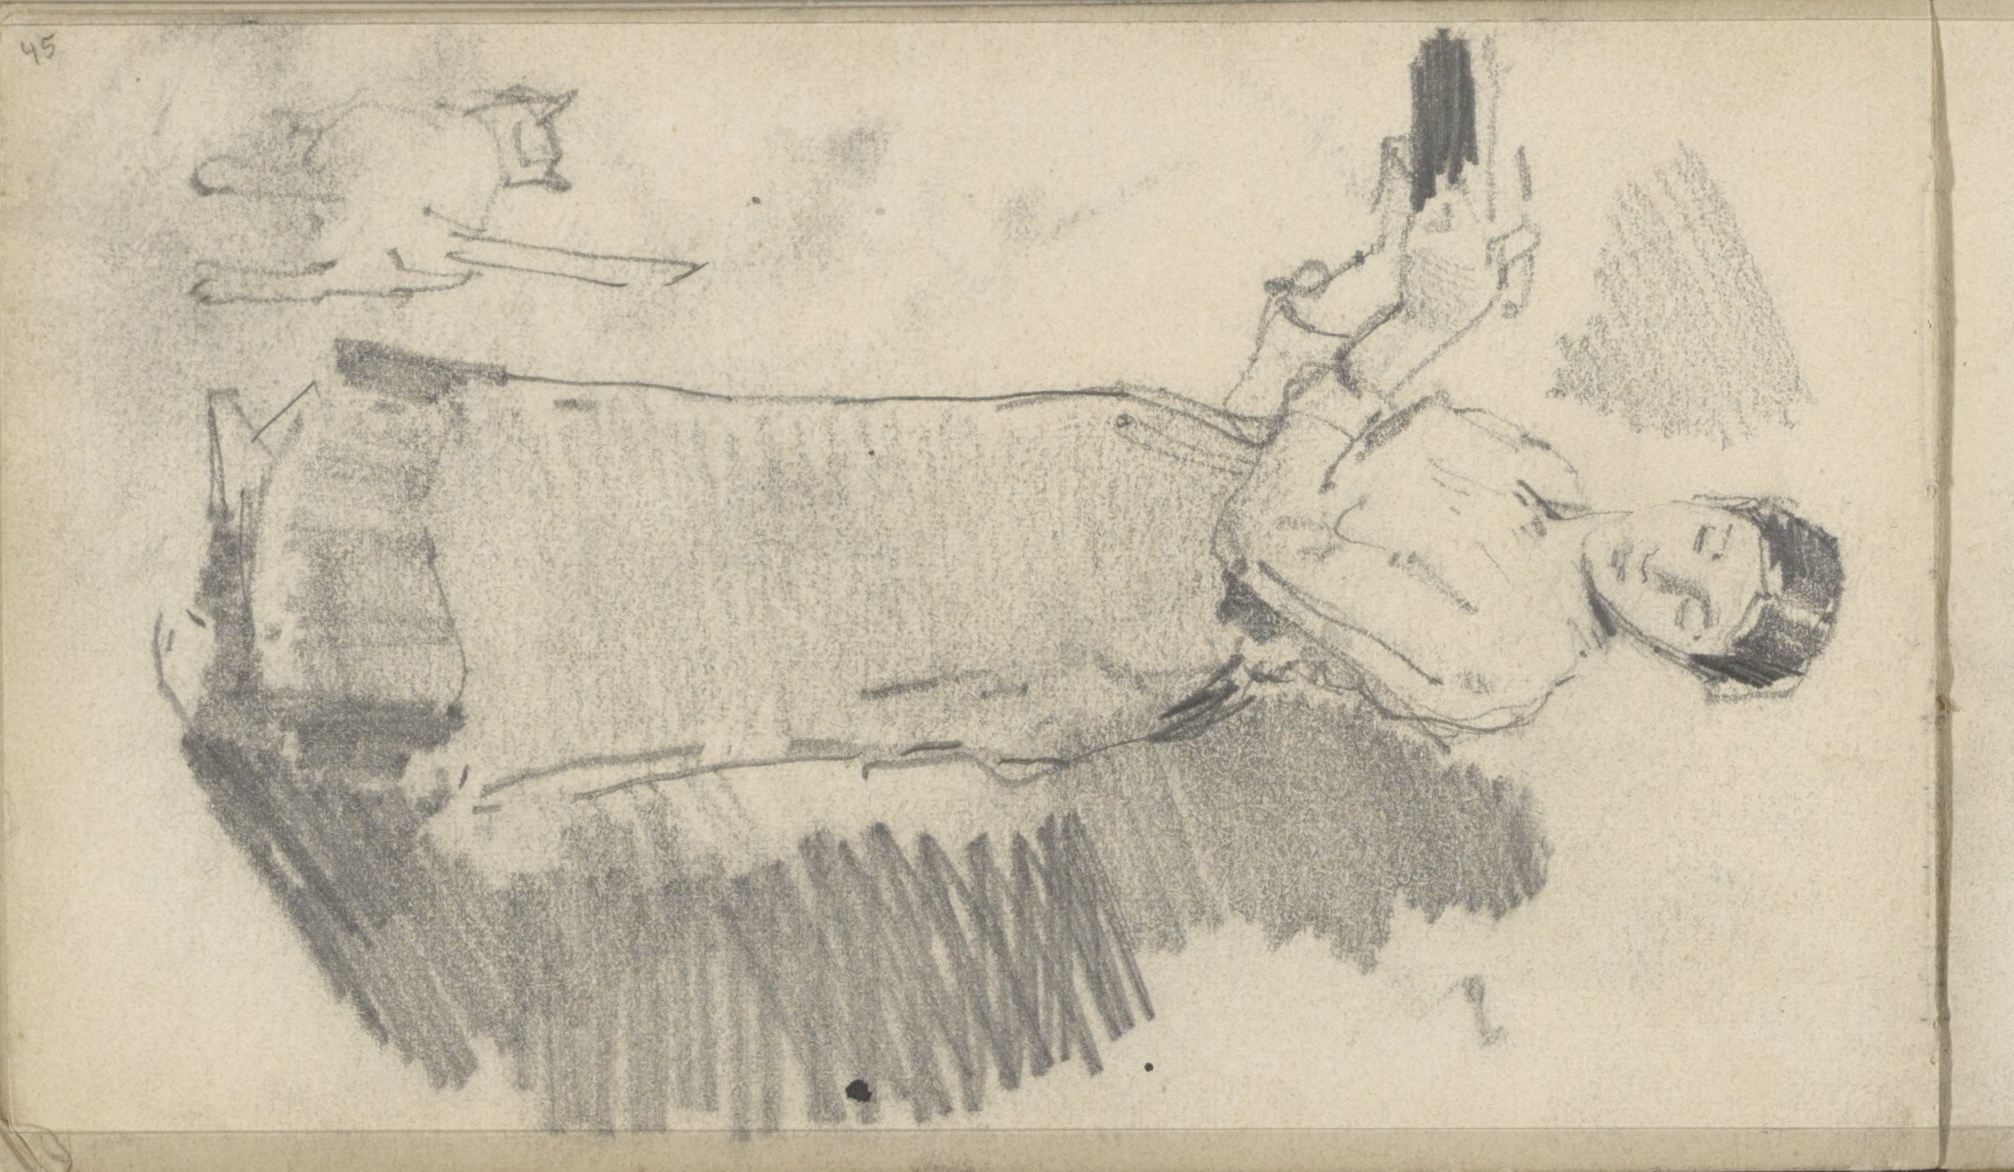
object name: sketchbook leaf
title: Staande vrouw en een kat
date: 1881-1883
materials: paper, pencil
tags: adult woman, carrying something, cat, standing figure - aa - female human figure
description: De vrouw heeft een voorwerp een haar handen. Pagina 45 uit een schetsboek met 30 bladen.